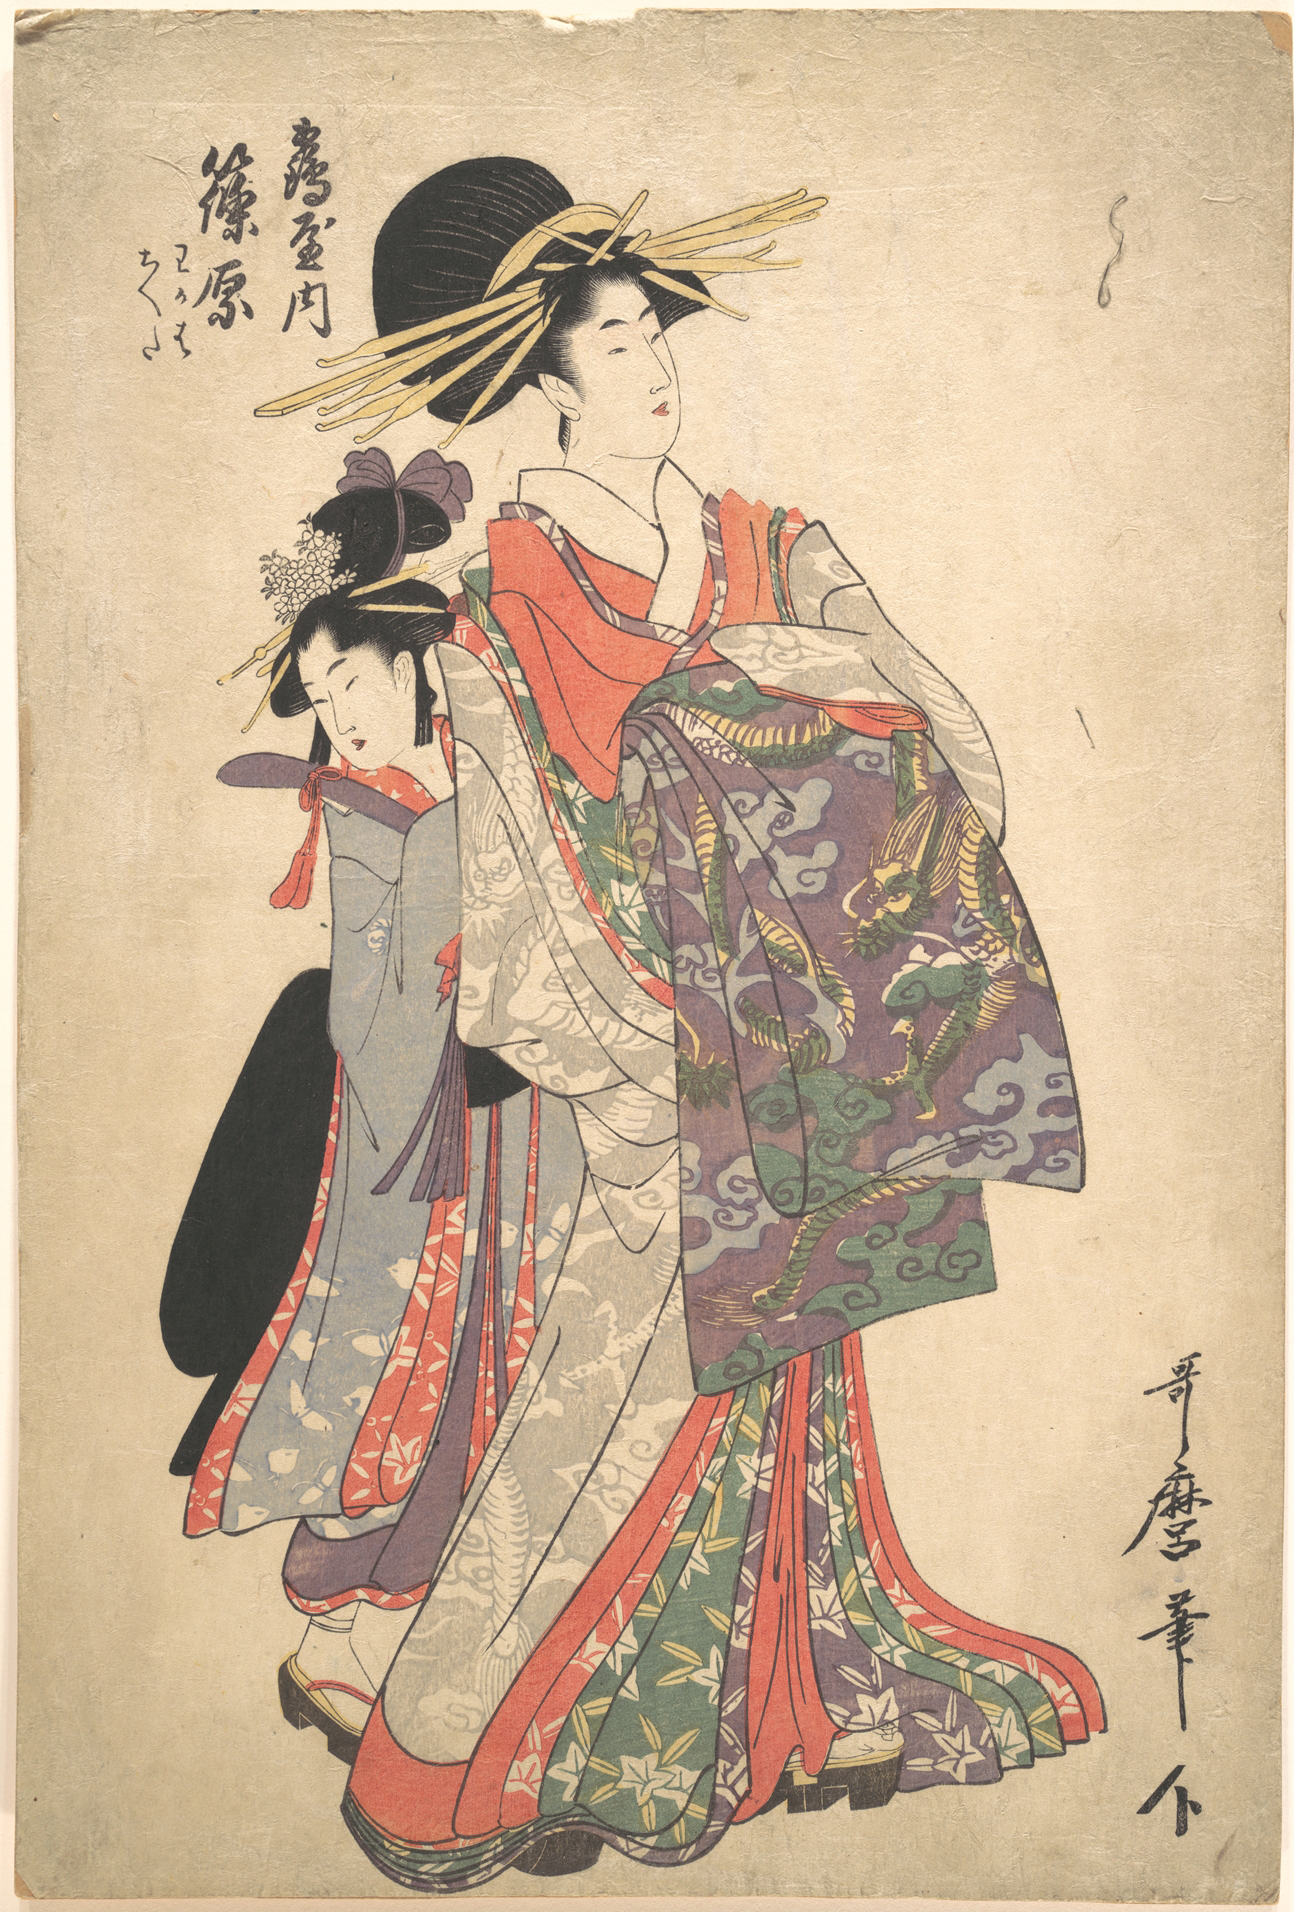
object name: print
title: Courtesan, Shinohara and Kamuro of Tsuruya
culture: japanese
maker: kitagawa utamaro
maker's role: artist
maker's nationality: japanese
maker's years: 1754-1806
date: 1767-1800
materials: ink, paper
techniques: woodblock print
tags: women